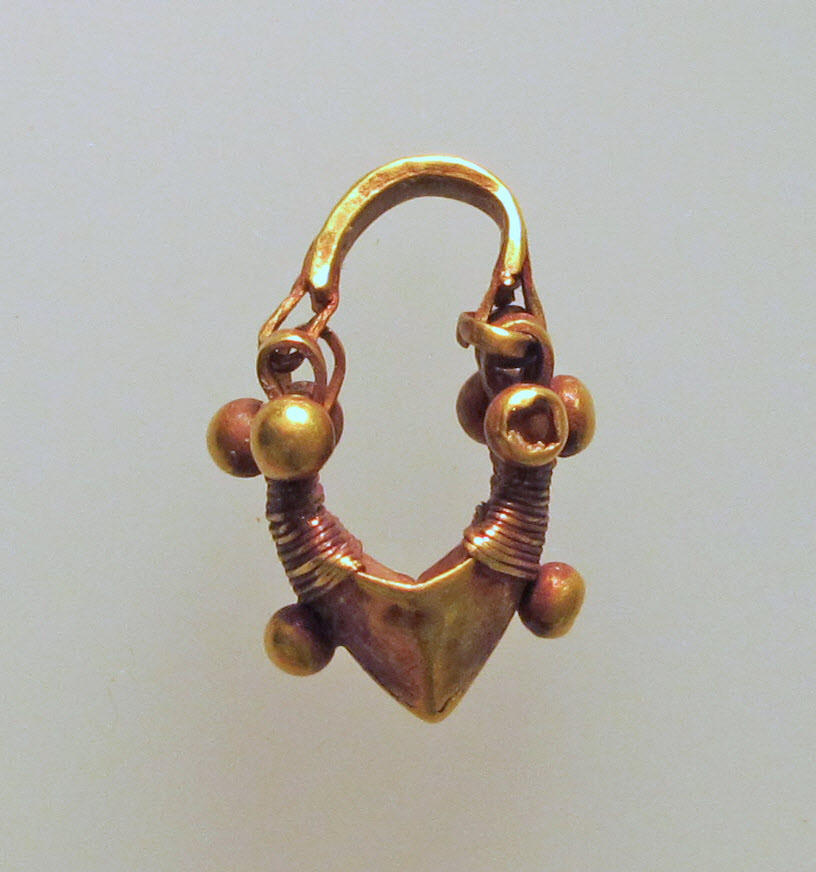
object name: earring, boat shaped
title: Earring, boat-shaped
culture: cypriot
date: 3900 BCE-100 CE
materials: gold